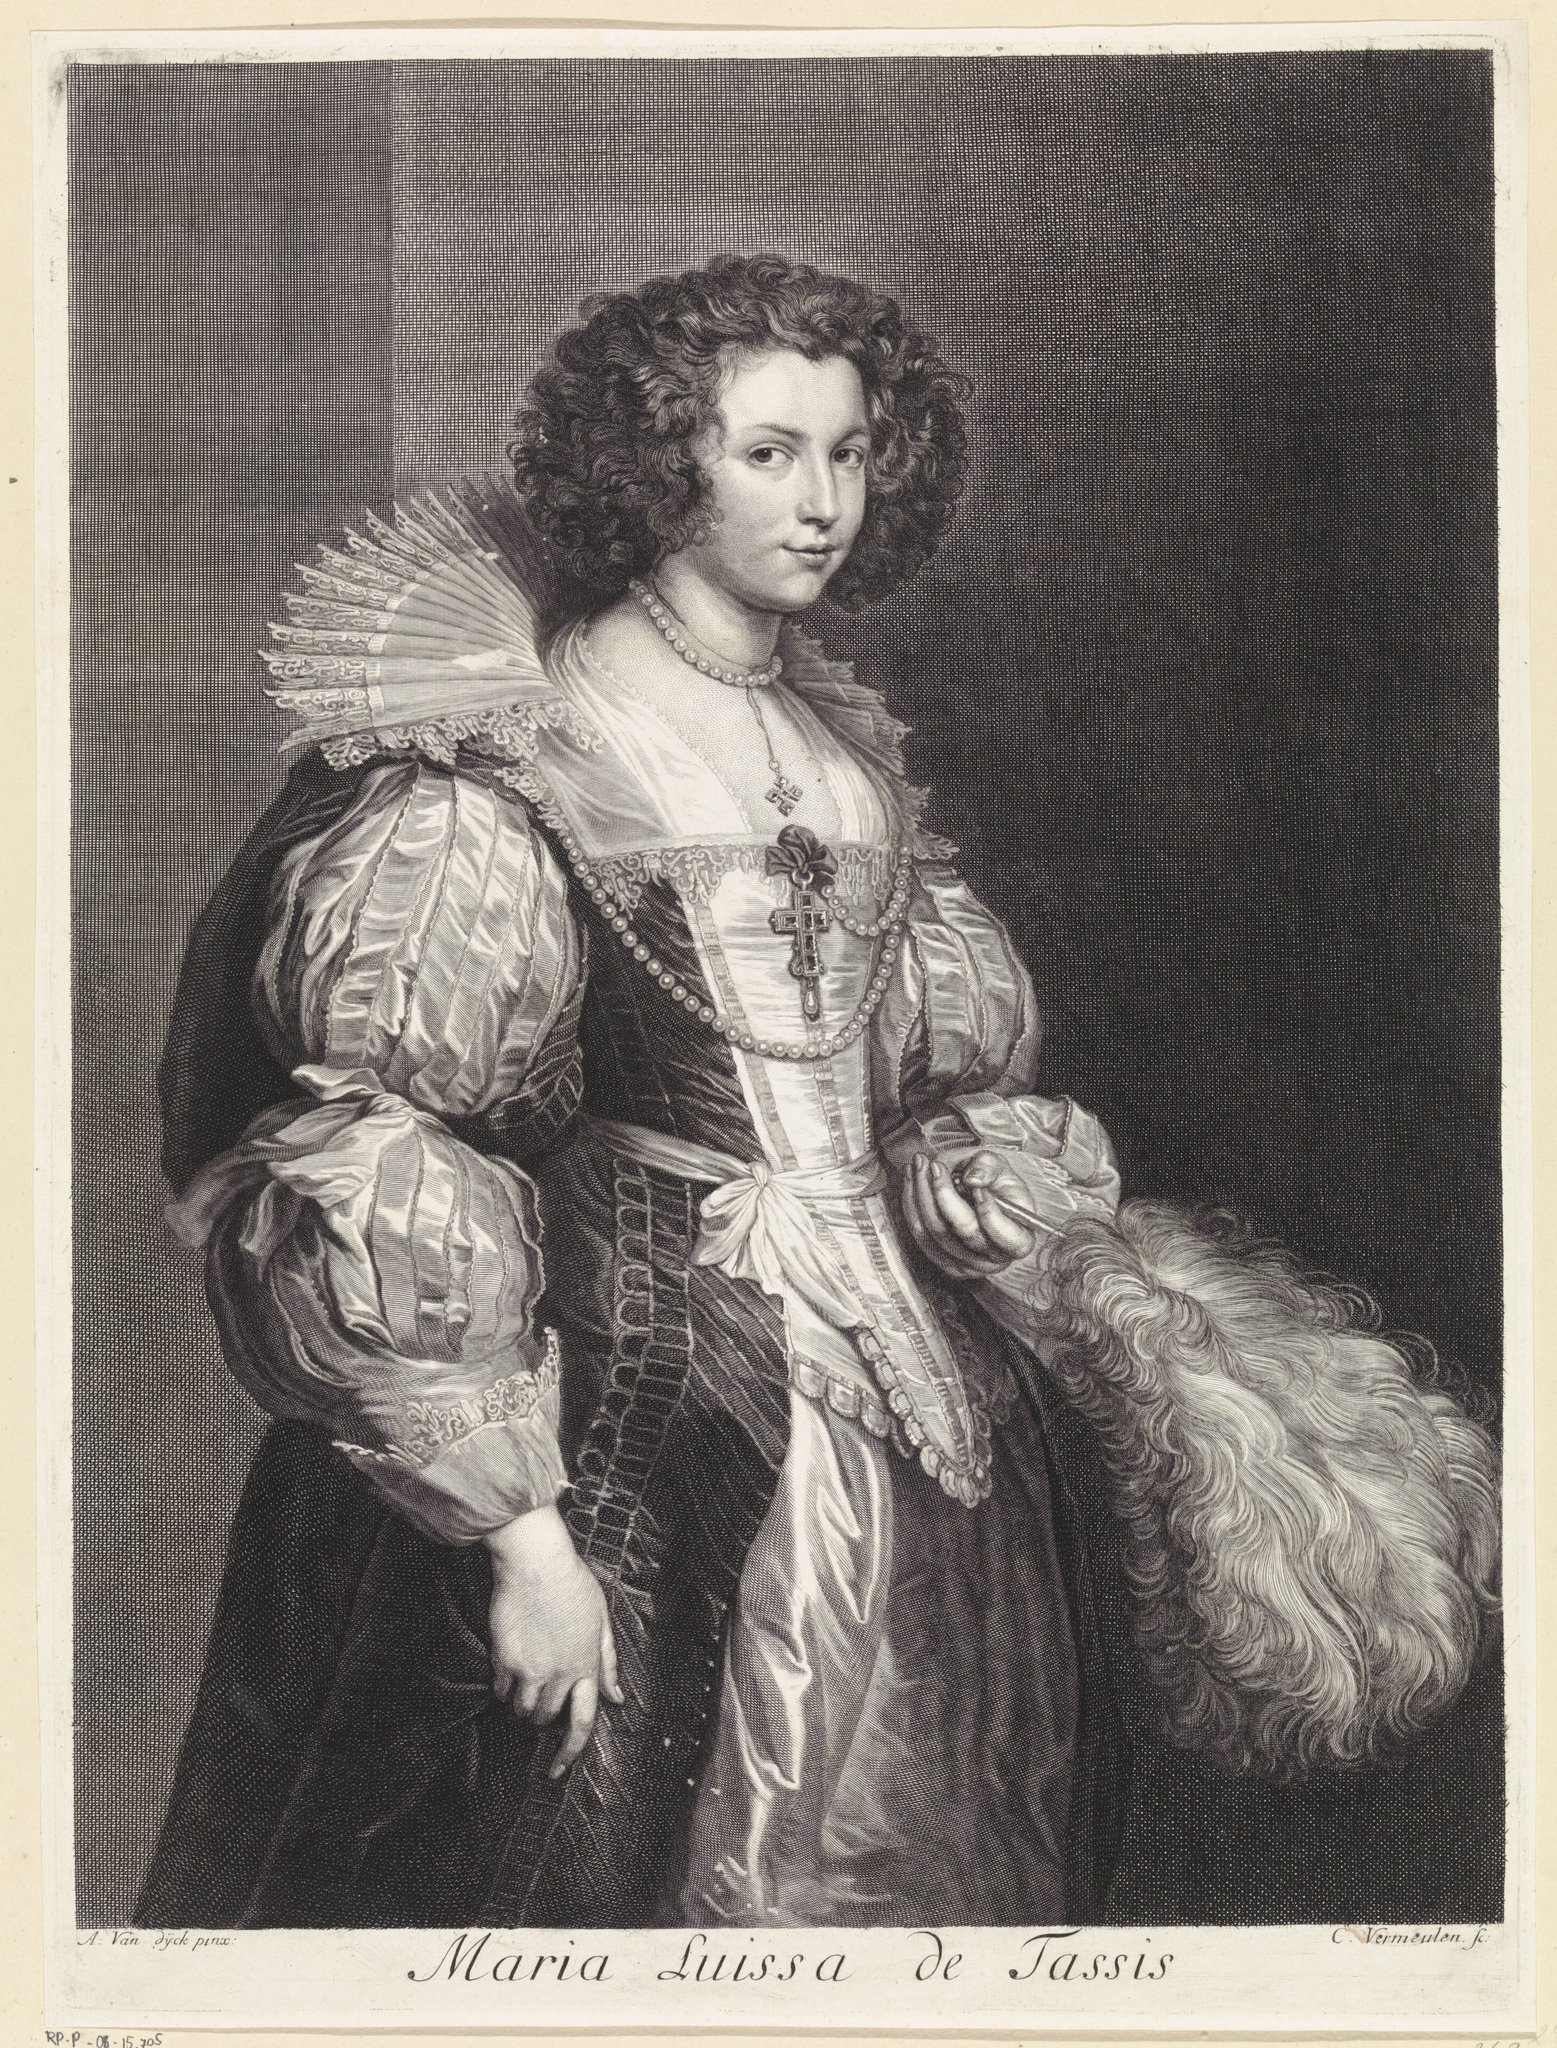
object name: print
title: Portret van Maria Louise von Thurn und Taxis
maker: anthony van dyck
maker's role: draughtsman, painter, print maker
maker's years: 1599-1641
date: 1654-1709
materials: paper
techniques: engraving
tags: fan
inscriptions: collector's mark: Lugt 240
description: Portret van Maria Louise von Thurn und Taxis, telg uit het geslacht van de keizerlijke postmeesters von Thurn und Taxis.